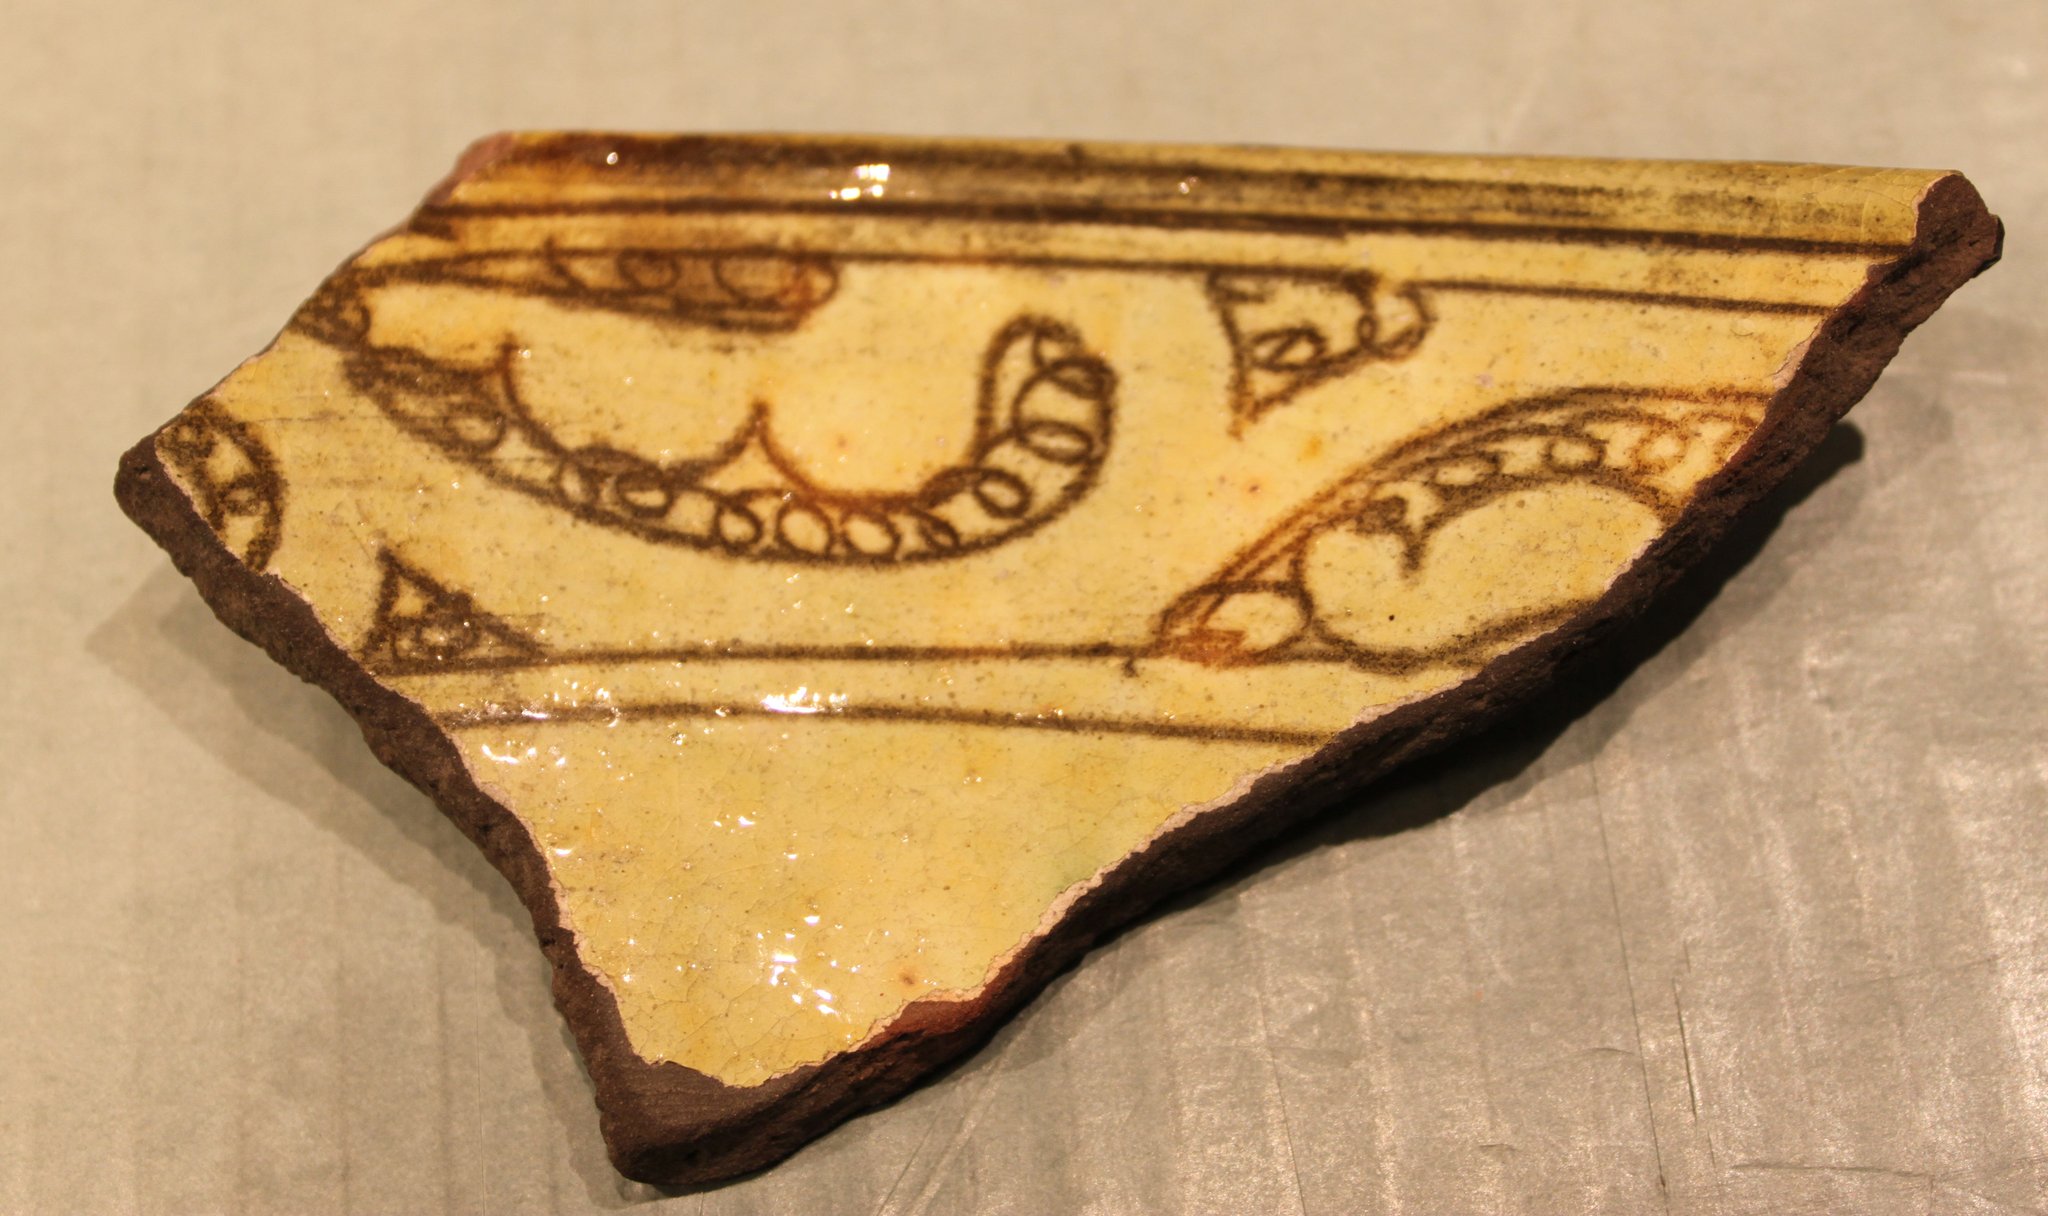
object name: fragment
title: Ceramic Fragment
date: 1301-1500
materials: earthenware, glaze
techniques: coloring, incising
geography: egypt